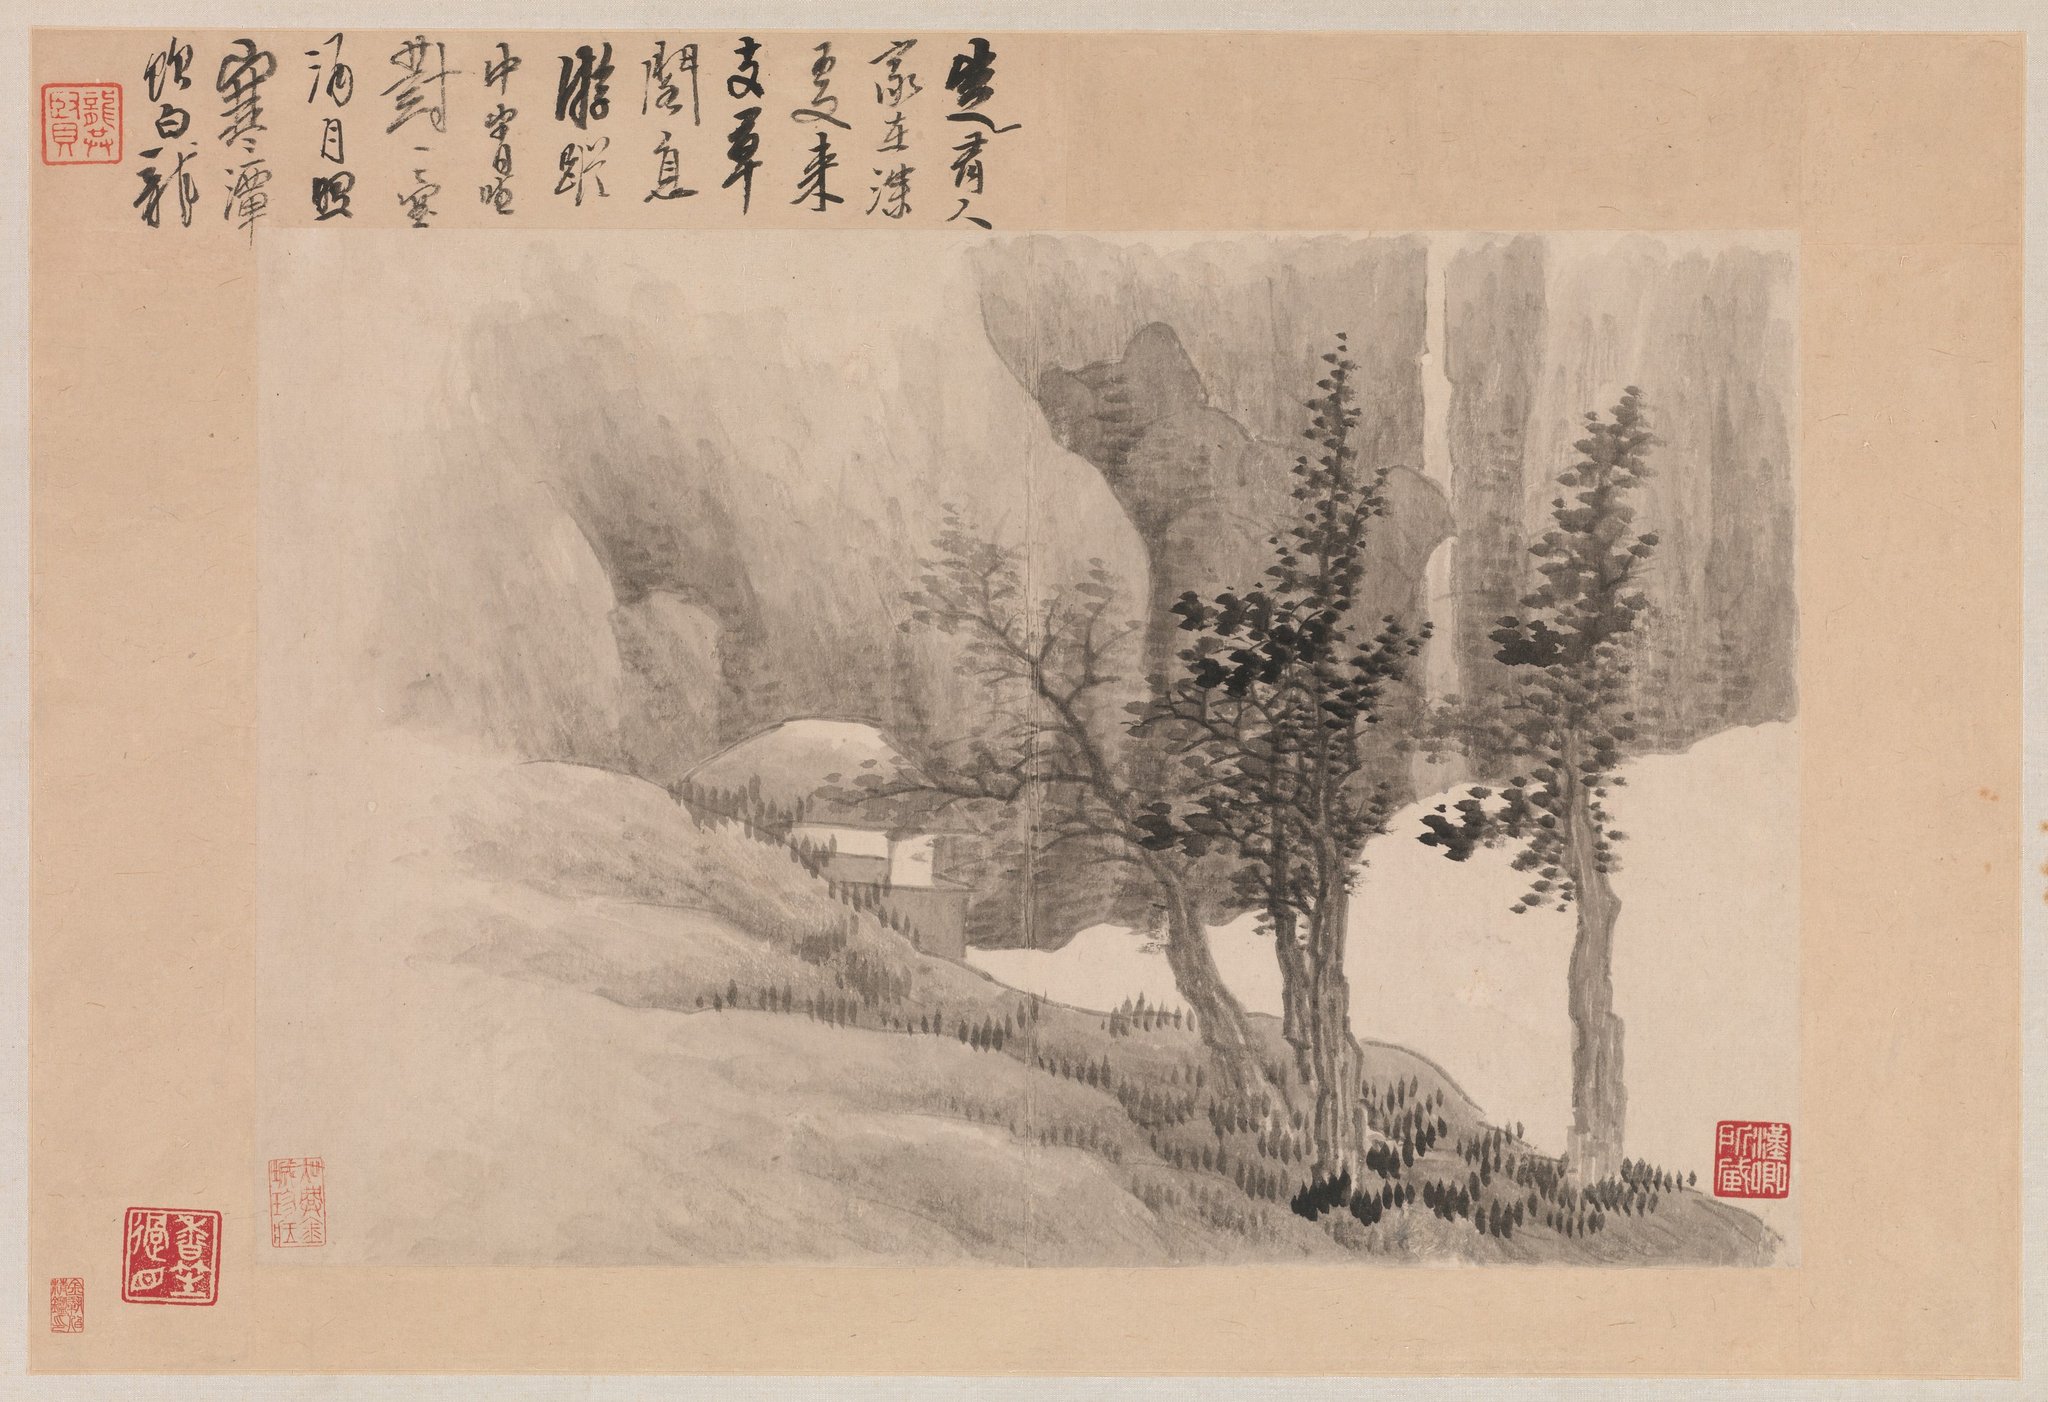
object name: album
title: Landscapes with Poems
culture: chinese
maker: gong xian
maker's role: artist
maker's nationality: chinese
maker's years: 1619-1689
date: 1688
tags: poetry,landscapes